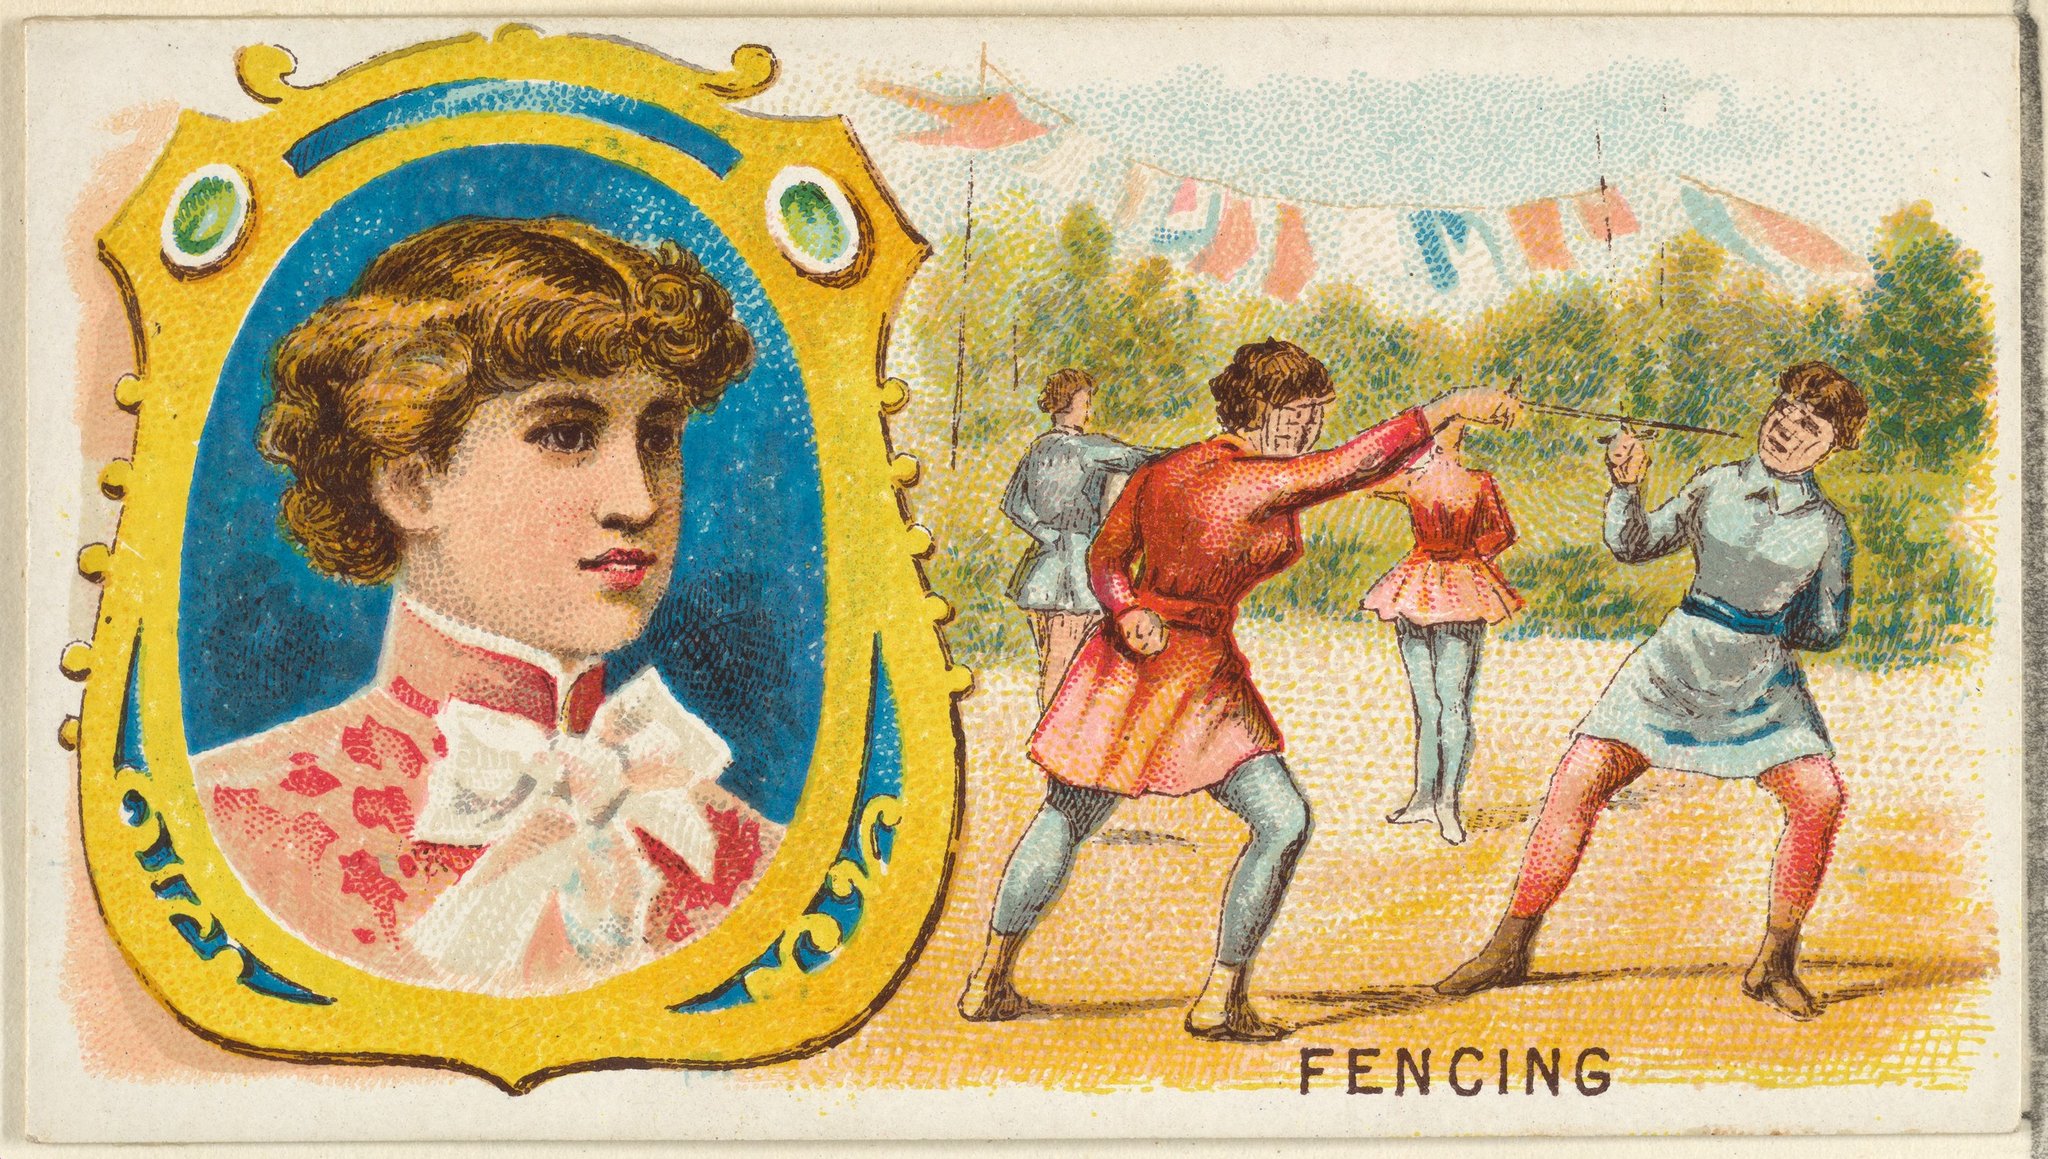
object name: print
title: Fencing, from the Games and Sports series (N165) for Old Judge Cigarettes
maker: goodwin & company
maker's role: publisher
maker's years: 1850-1950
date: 1889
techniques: color lithograph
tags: women,fencing